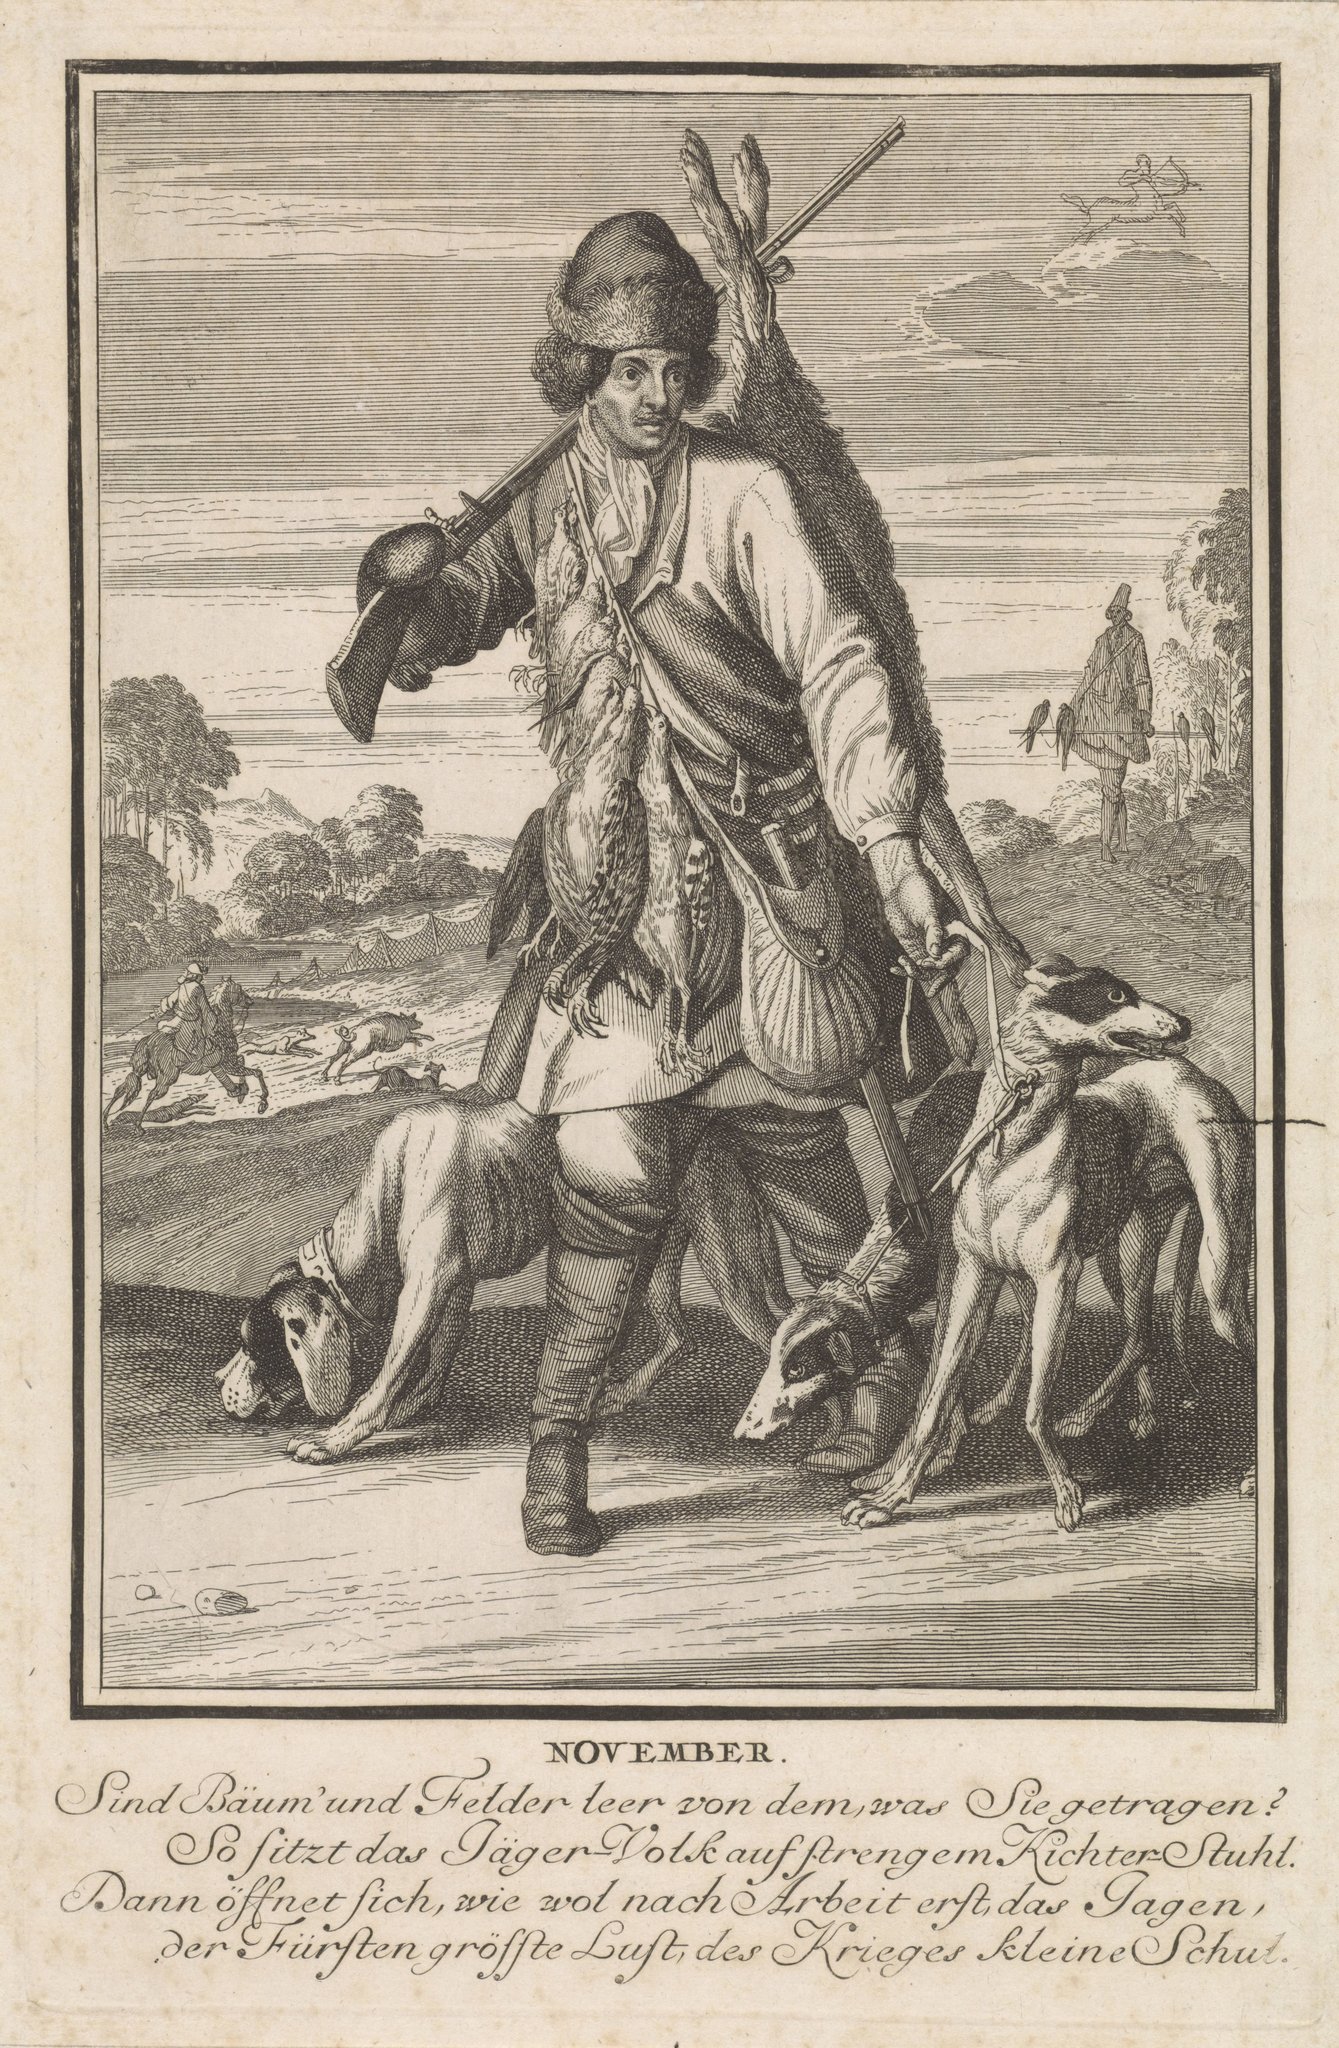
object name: print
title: November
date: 1698-1702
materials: paper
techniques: engraving, etching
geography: nuremberg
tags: landscape symbolizing november, november; 'novembre' (ripa), hunting dogs, boar-hunting, november and its 'labours', sagittarius (zodiacal sign of november), bird hunting, return from the hunt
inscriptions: collector's mark: Lugt 2228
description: De maand november. Op voorgrond een jager die terugkomt van de jacht. Hij voert drie honden mee en draagt zijn jachtbuit op zijn lichaam. Op de achtergrond een zwijnenjacht en een vogeljacht. De prent heeft een Duits onderschrift van vier regels over de maand november.